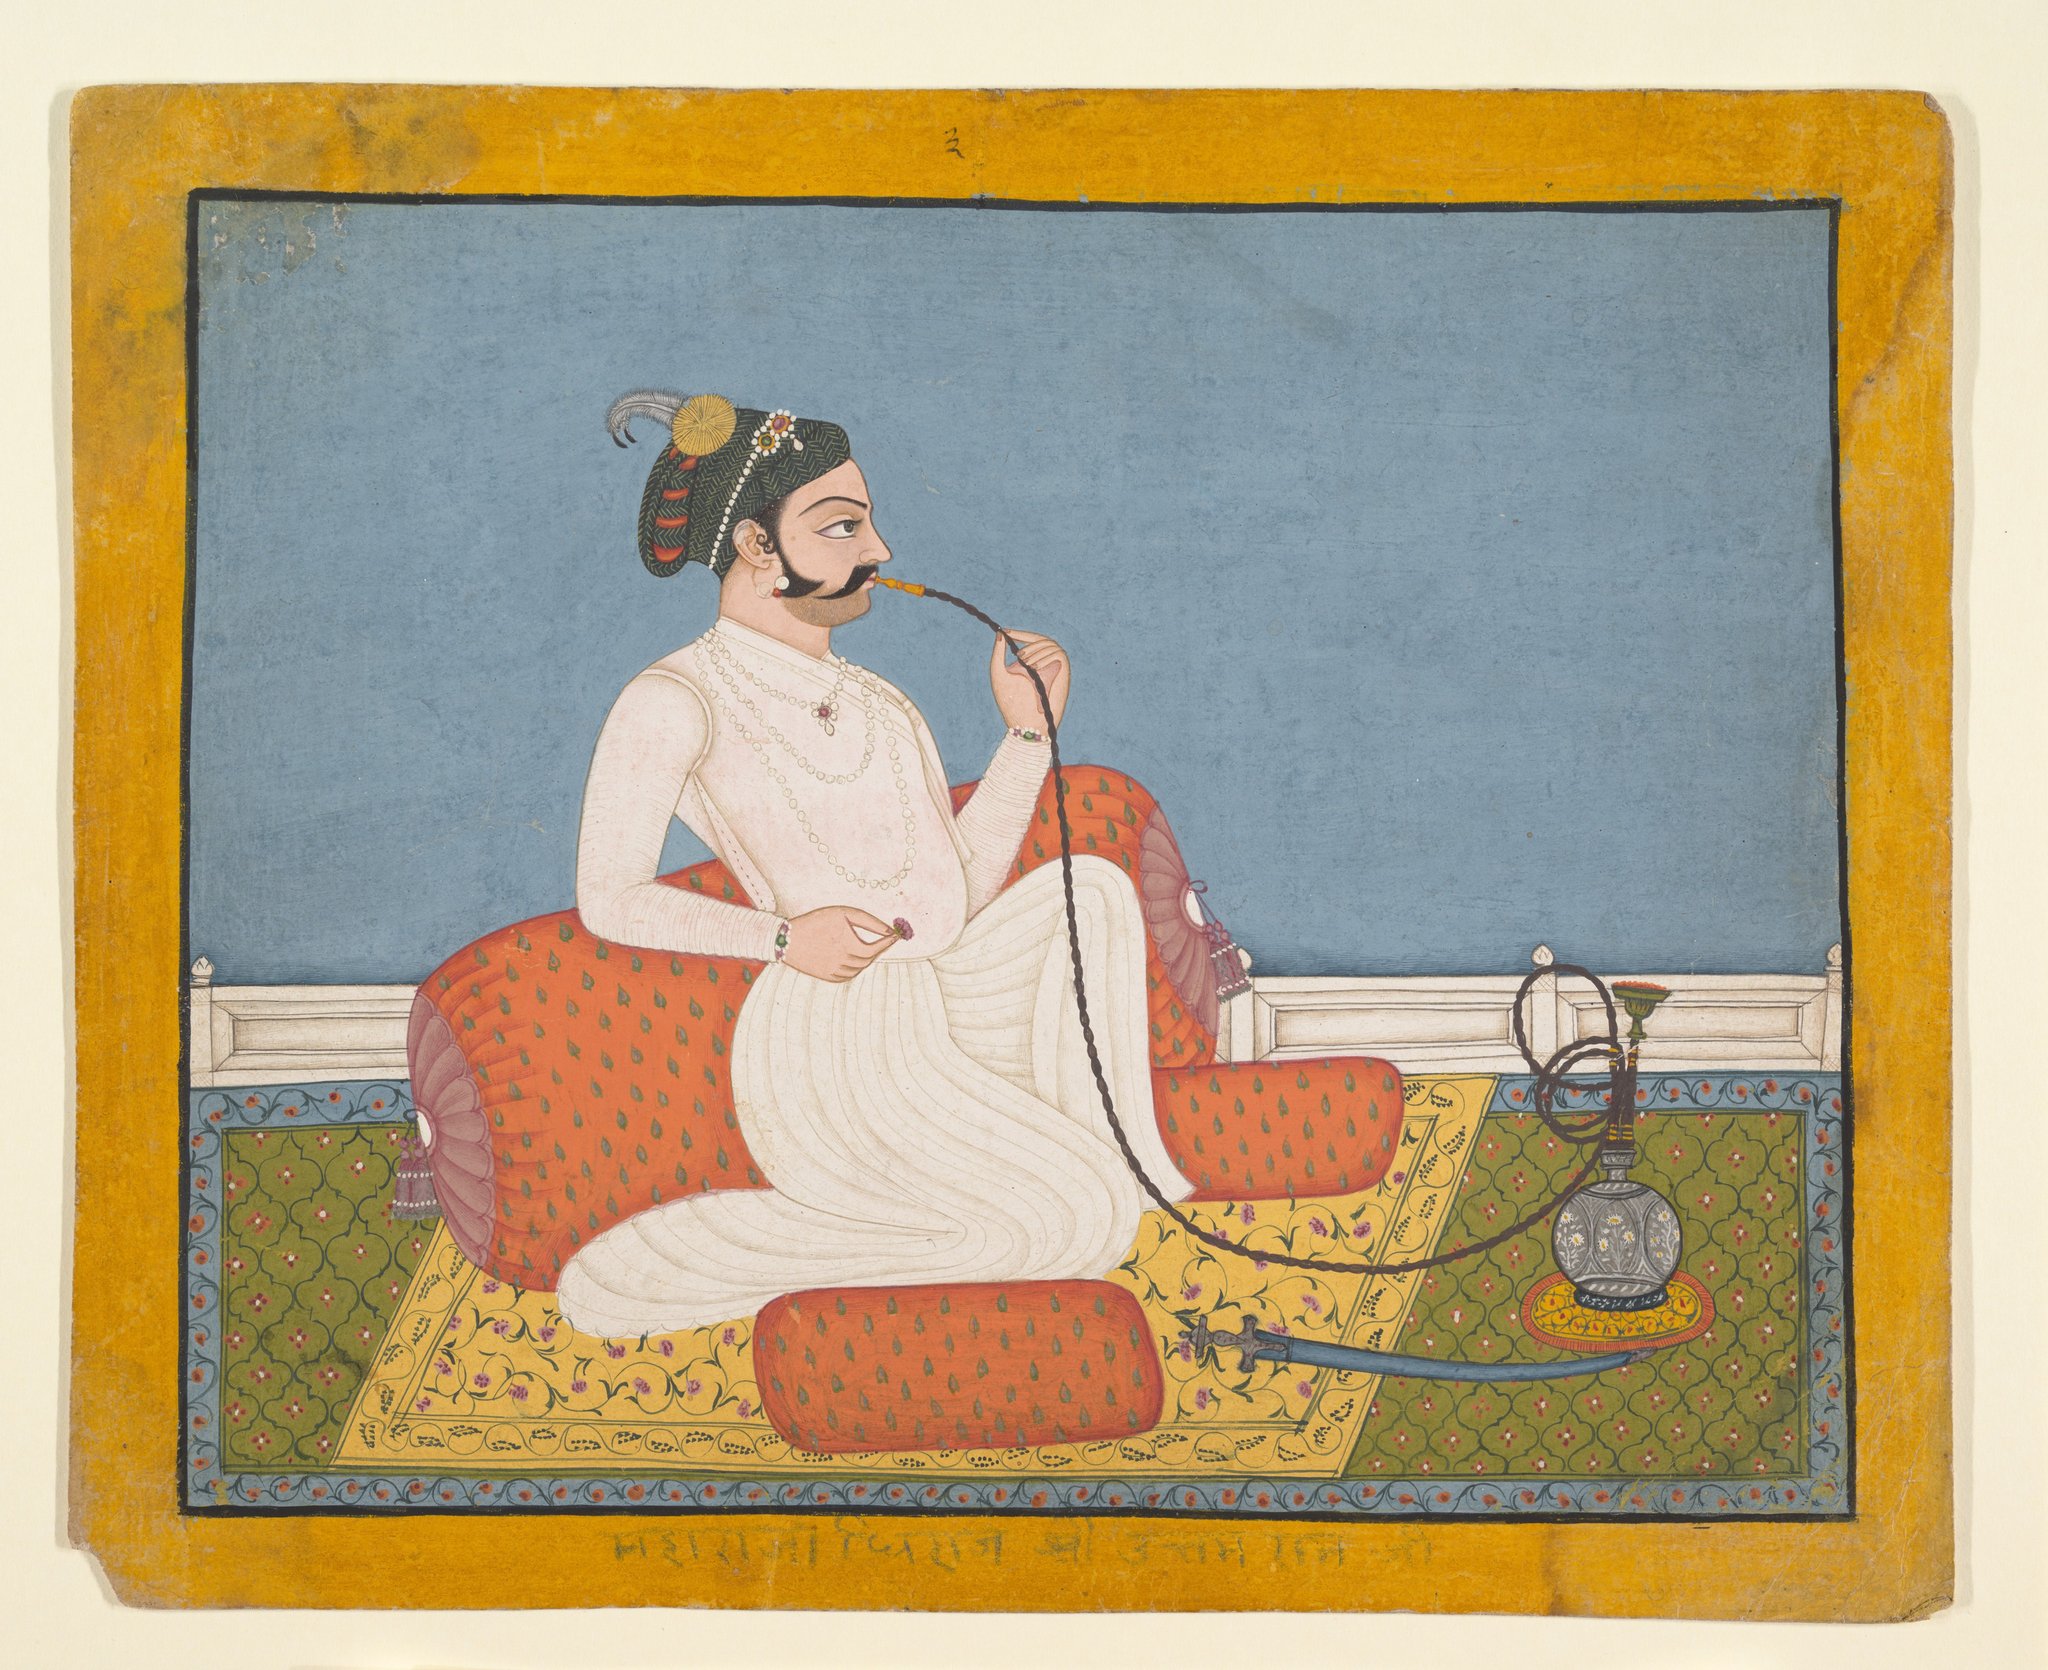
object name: painting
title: Portrait of Thakur Utham Ram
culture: indian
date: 1760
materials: ink, paper, silver, watercolor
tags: men,smoking,hookah